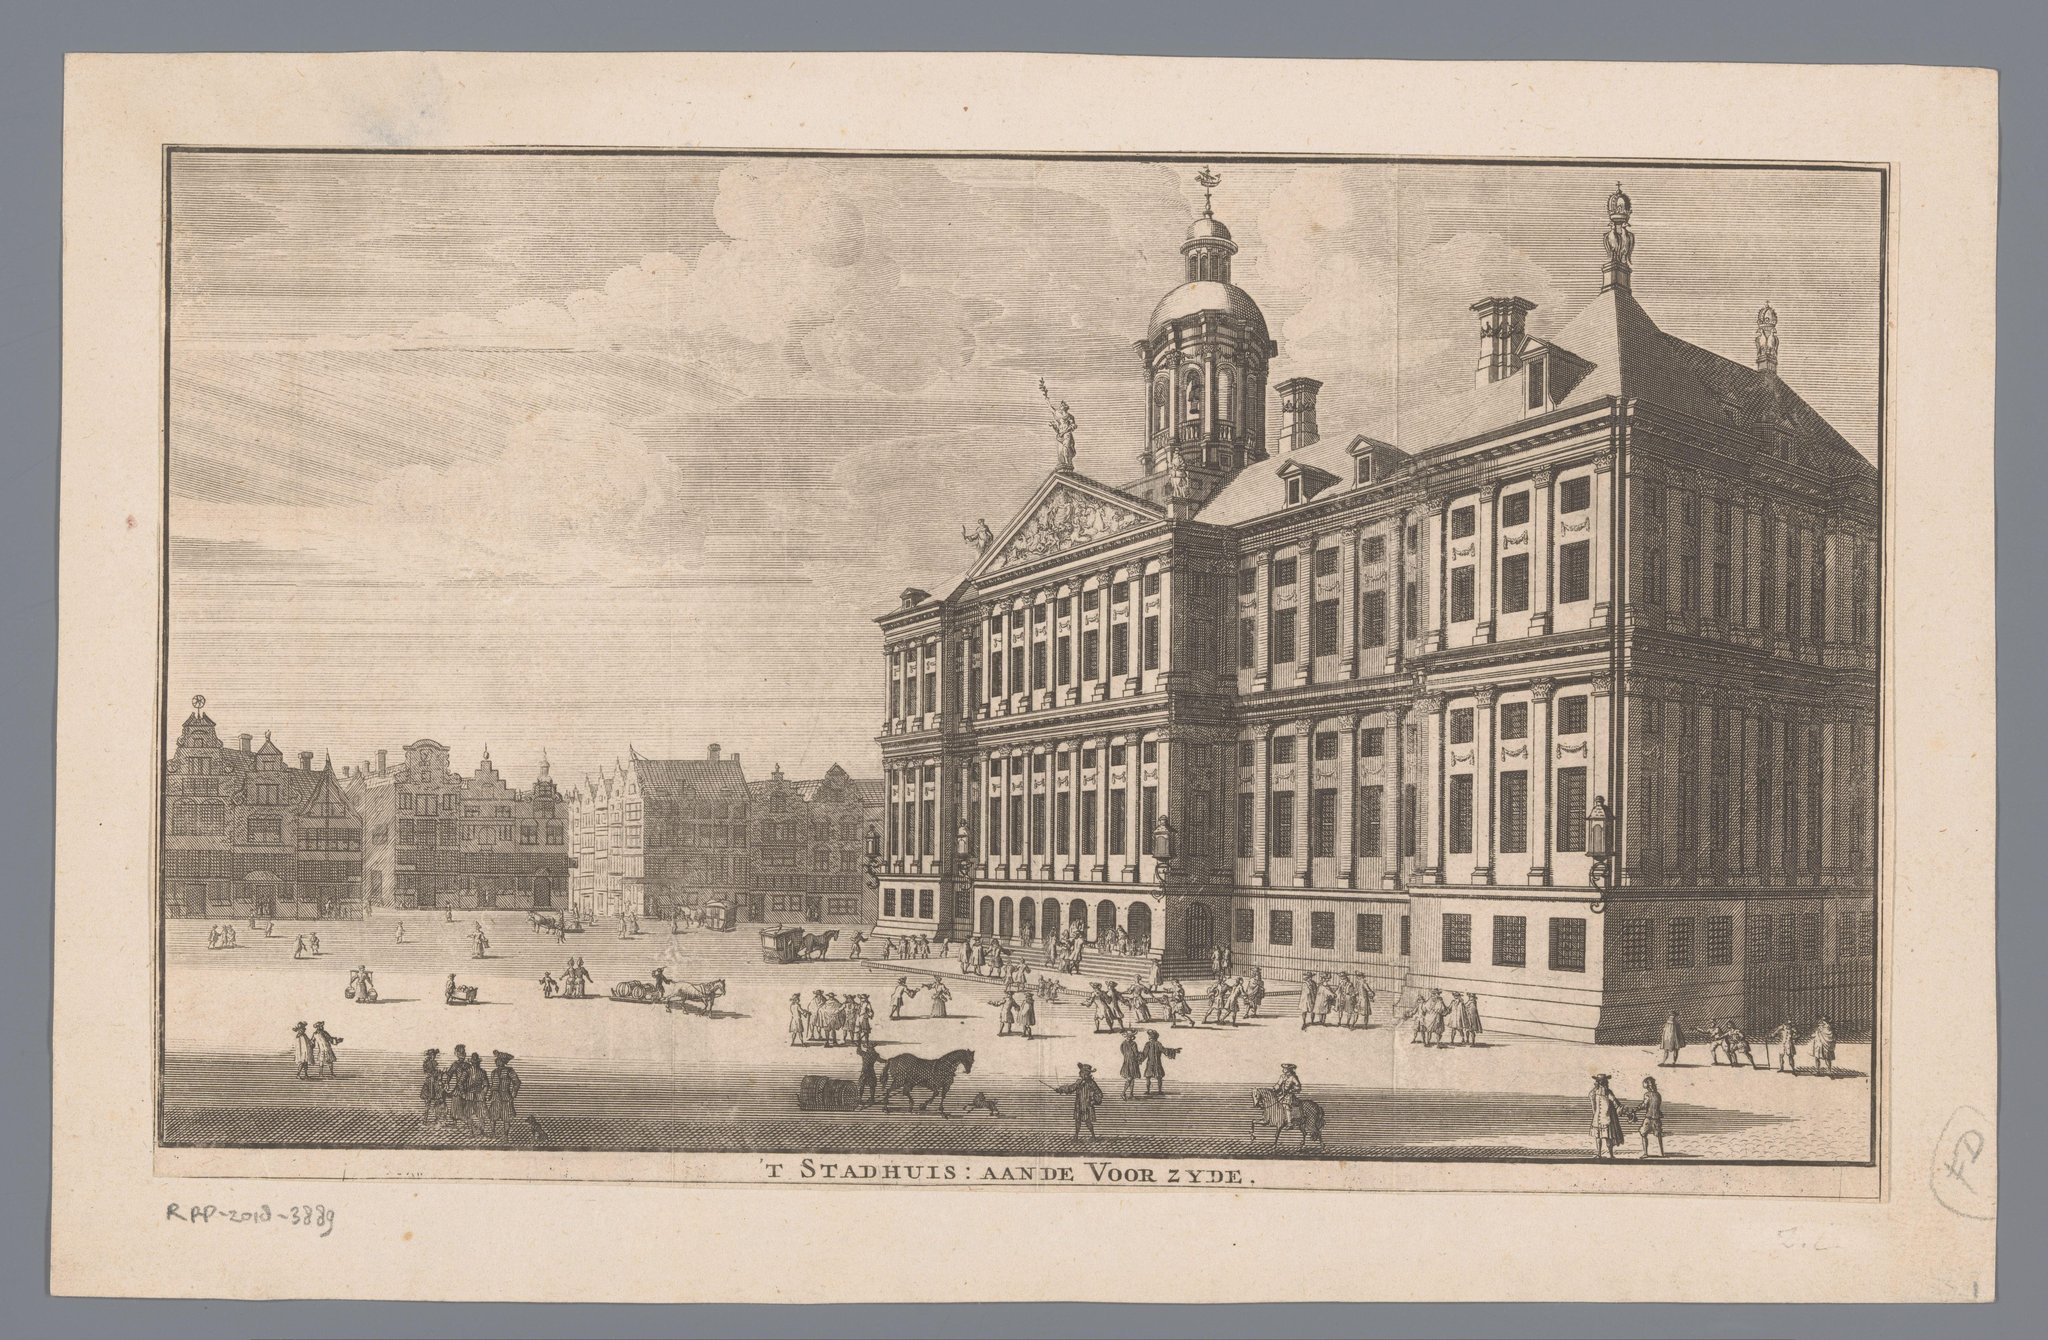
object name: print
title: Gezicht op het Koninklijk Paleis te Amsterdam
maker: albert de putter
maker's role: print maker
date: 1700-1725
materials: paper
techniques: etching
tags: palace, royal palace of amsterdam